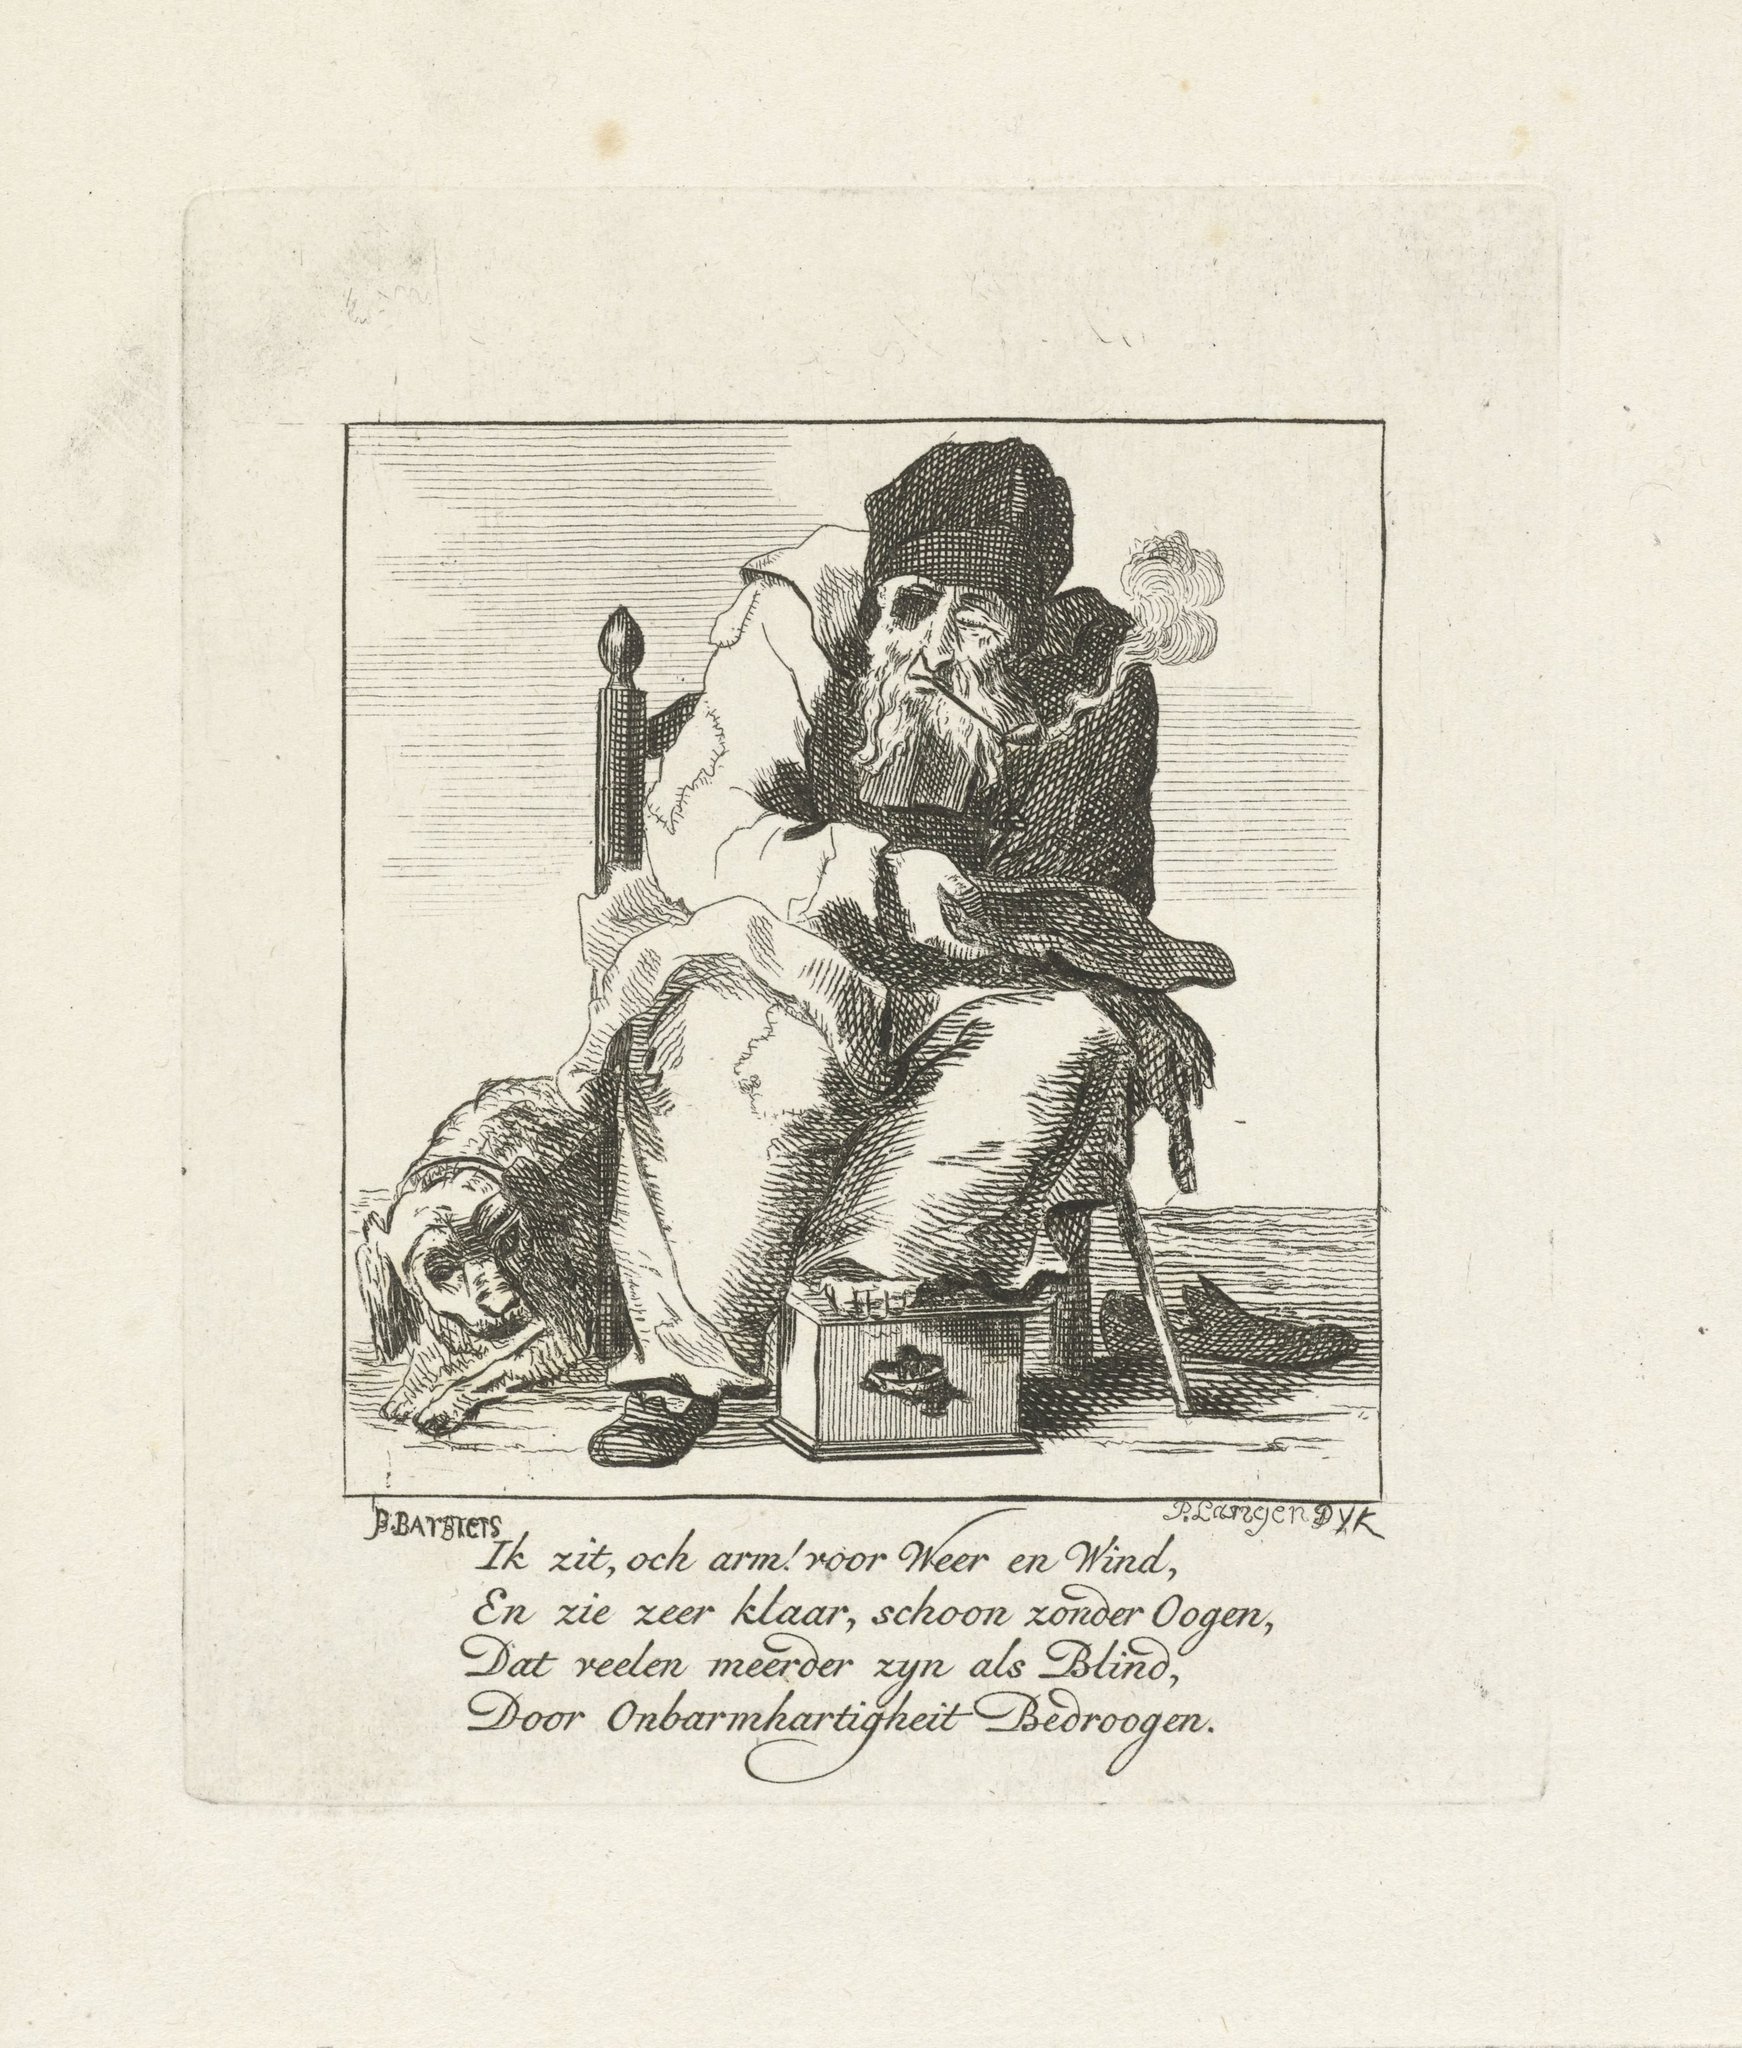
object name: print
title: Amsterdamse straatfiguren rond 1770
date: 1770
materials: paper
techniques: engraving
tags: pipe ~ tobacco, blind, blindness, beggar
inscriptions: collector's mark: Lugt 240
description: Een oude blinde man zit pijprokend op een stoel en bedelt om geld met een uitgestoken hoed. Zijn linkervoet rust op een stoof, naast hem ligt een hond op de grond. In de marge een vierregelig vers in het Nederlands. Onderdeel van een serie prenten van Amsterdamse straatfiguren rond 1770.